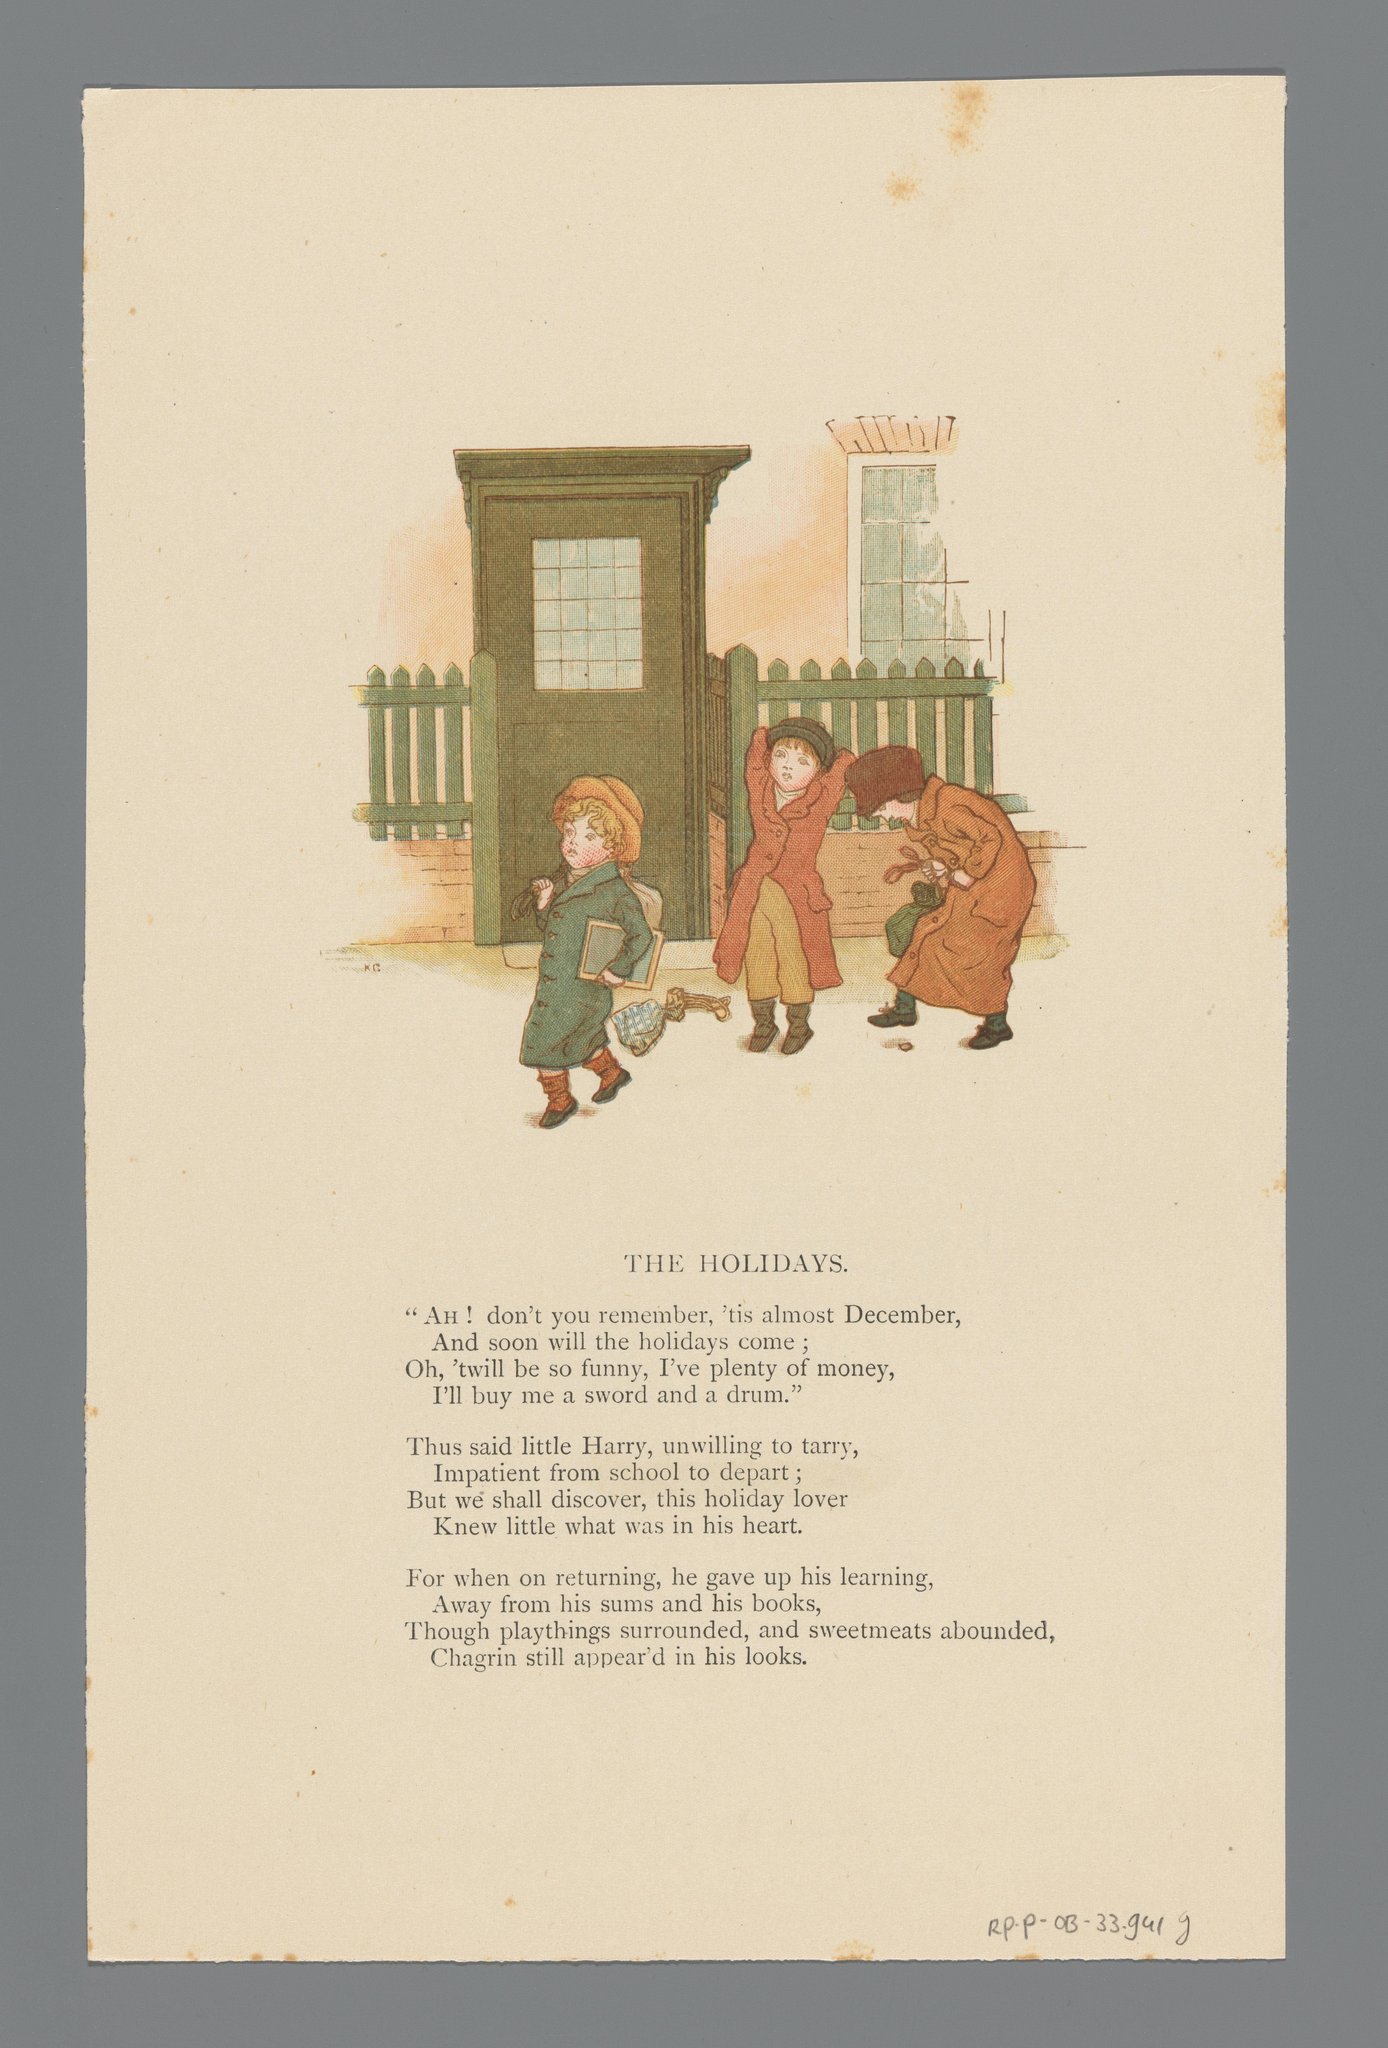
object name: book illustration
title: Drie kinderen bij een voordeur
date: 1883-1927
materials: paper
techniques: wood engraving, letterpress printing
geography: london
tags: housing, child (+ three persons), closed door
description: Prent uit: Jane en Ann Taylor. Little Ann and other poems. Londen: George Routledge & Sons, [1883], p. 58. Of een latere uitgave.